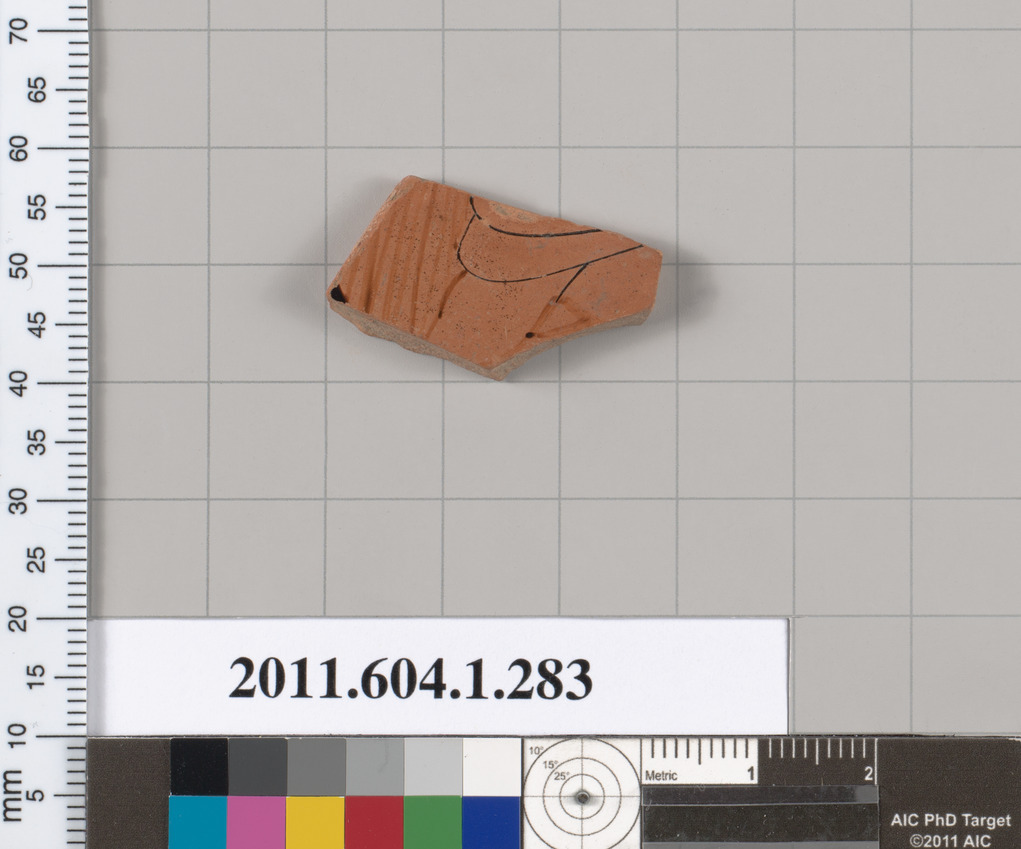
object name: kylix fragment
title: Terracotta fragment of a kylix (drinking cup)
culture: greek, attic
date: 475-451 BCE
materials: terracotta